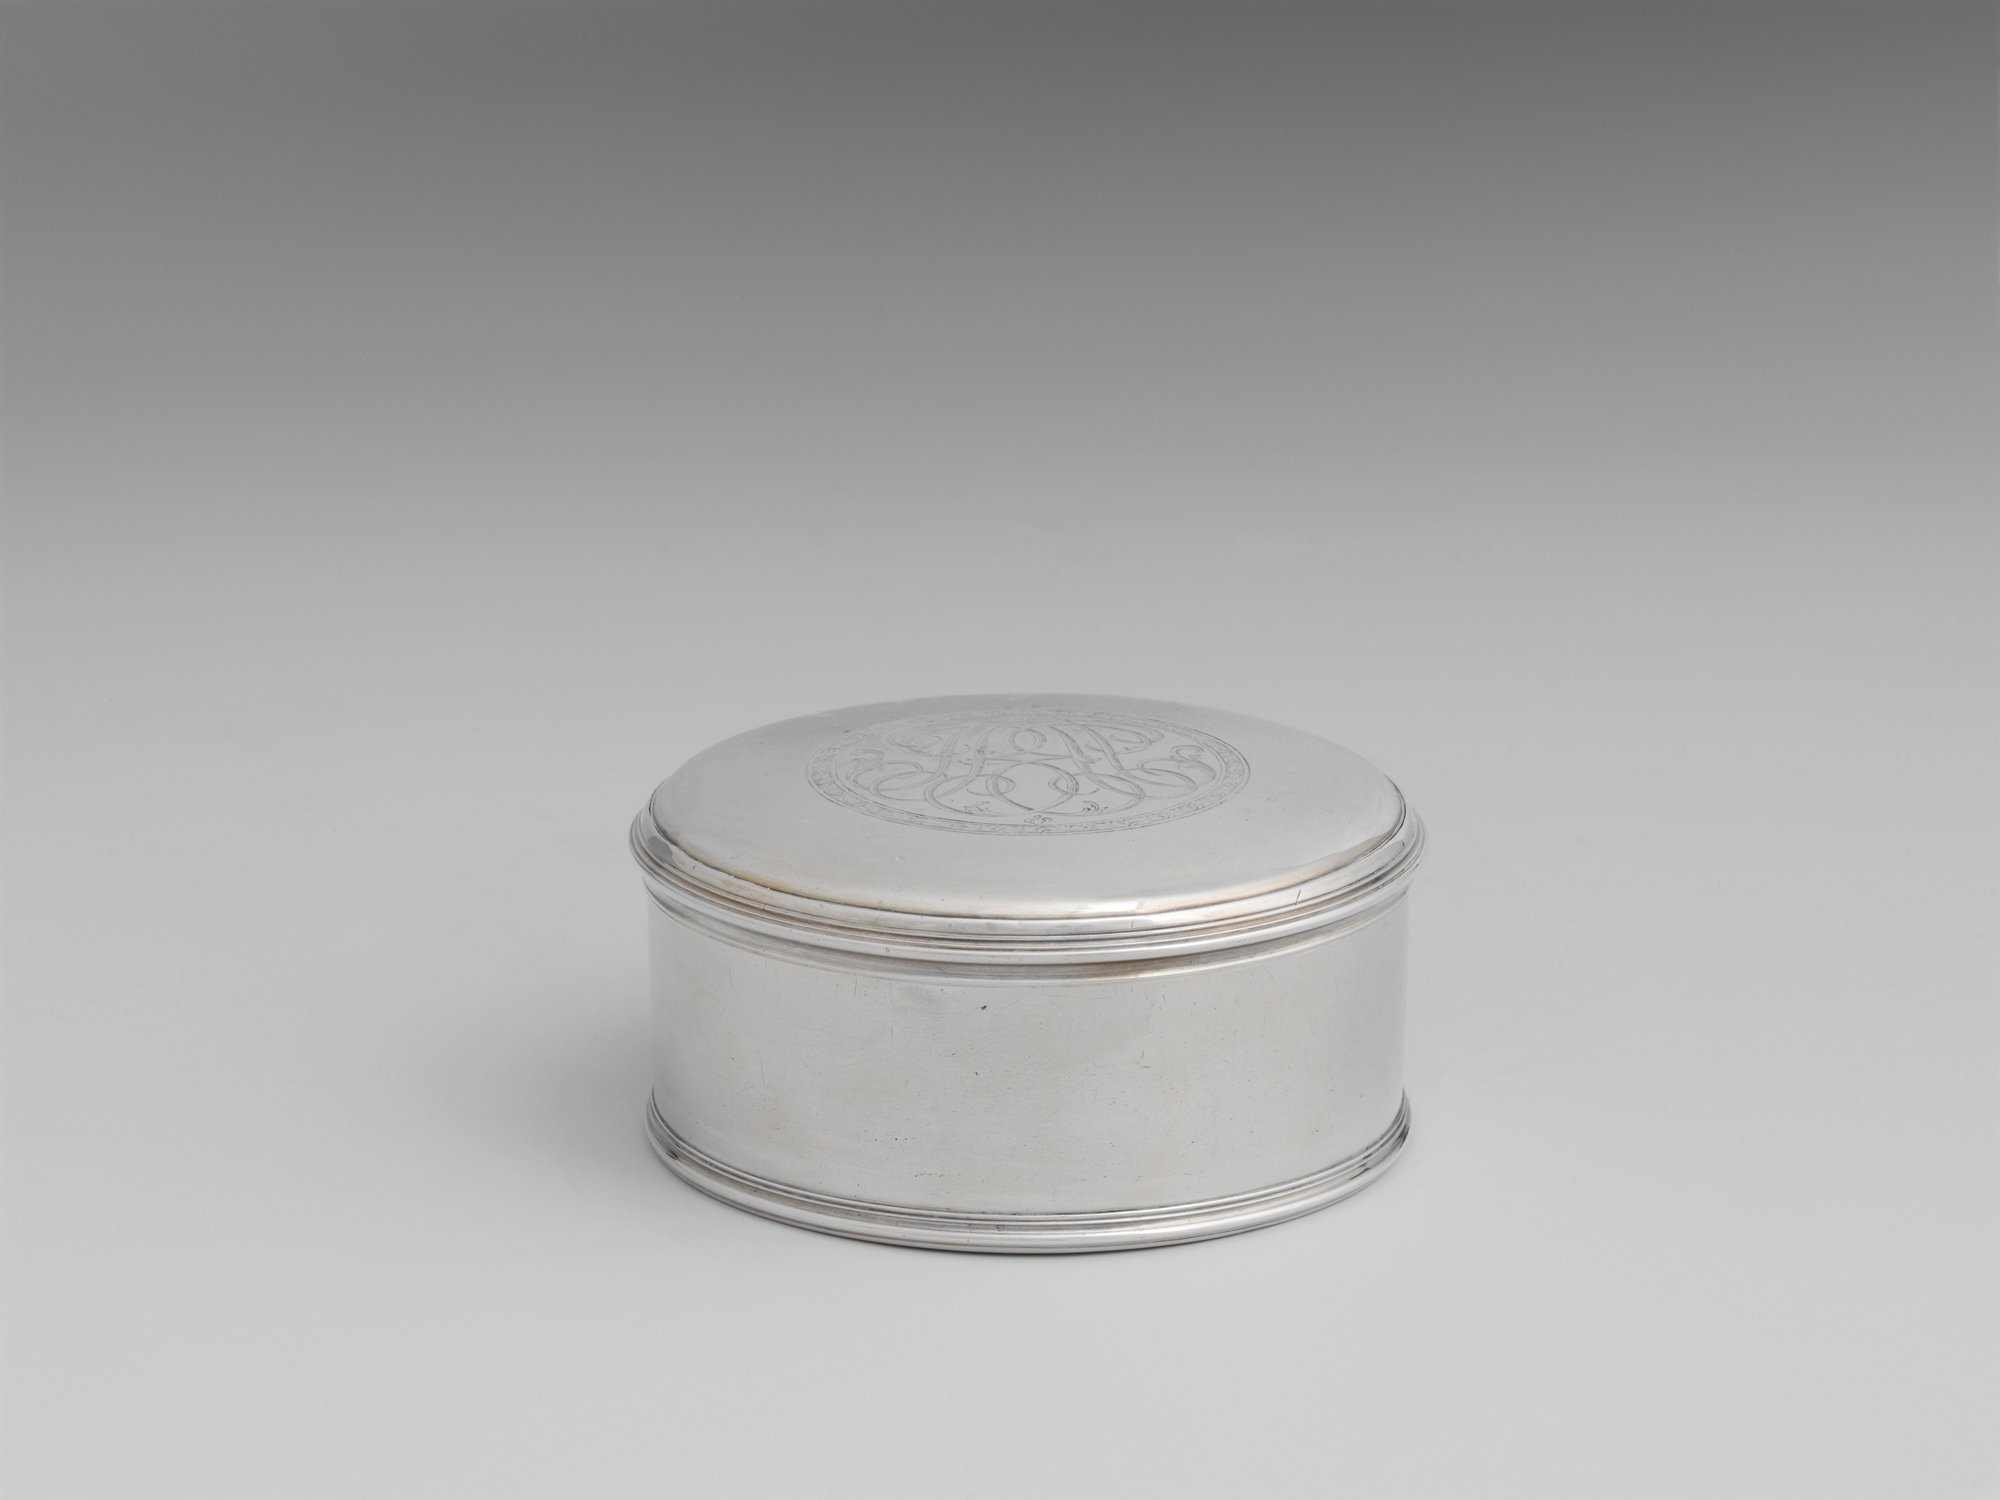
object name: box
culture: american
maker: elias pelletreau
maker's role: maker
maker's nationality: american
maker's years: 1726-1810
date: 1753-1776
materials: silver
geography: united states